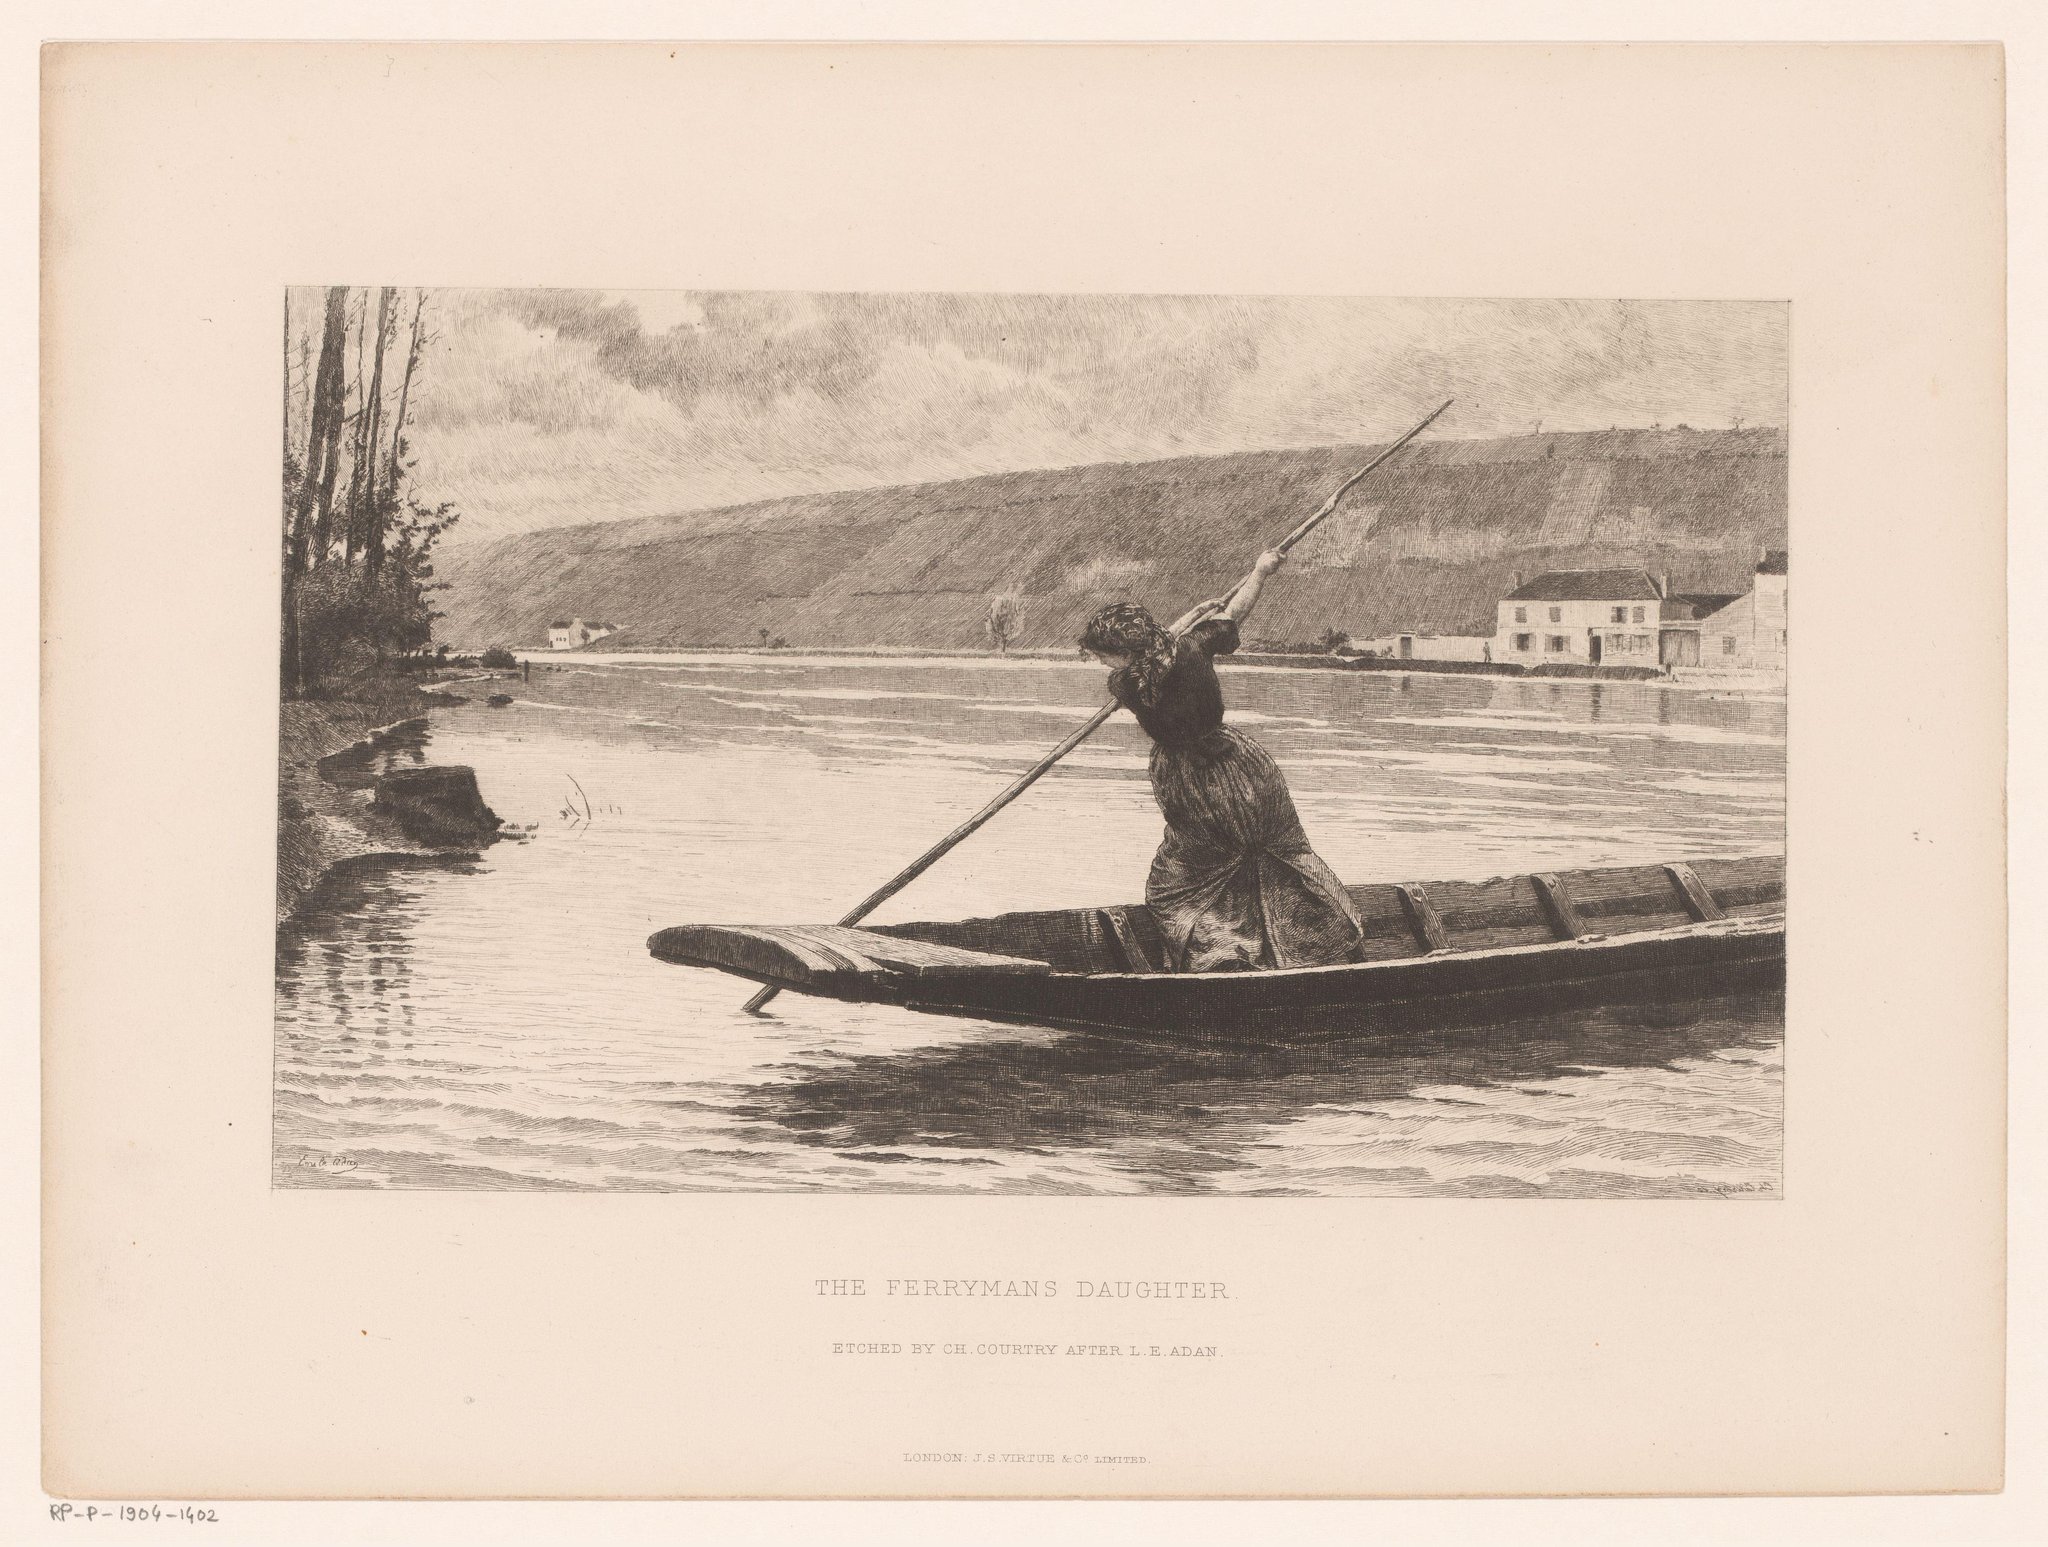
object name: print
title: Riviergezicht met een jonge vrouw in een gondel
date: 1856-1897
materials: paper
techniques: etching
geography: london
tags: river, gondola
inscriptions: collector's mark: Lugt 2228